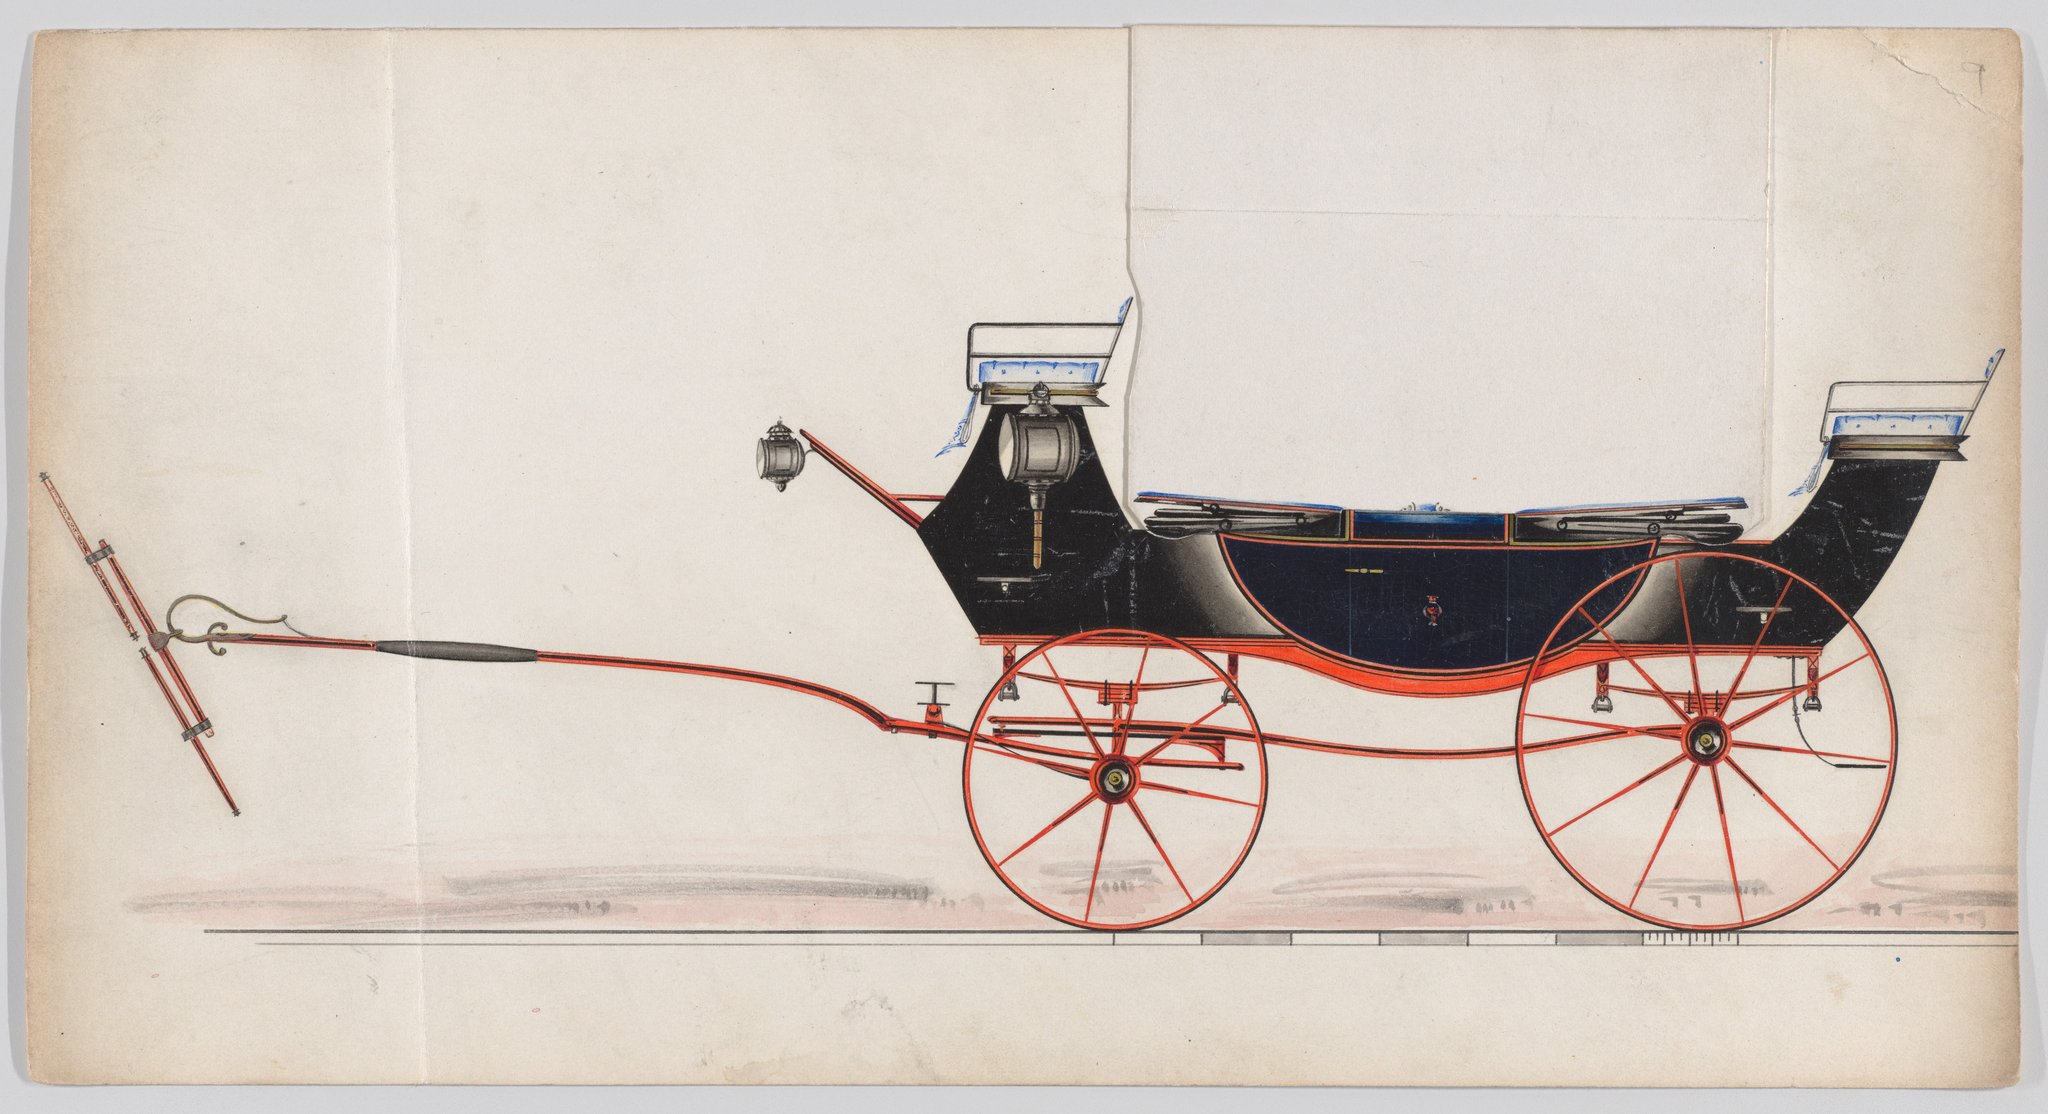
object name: drawing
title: Design for Landau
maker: brewster & co.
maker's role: manufacturer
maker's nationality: american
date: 1850-1870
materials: gouache, gum arabic, ink, watercolor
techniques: pen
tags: carriages